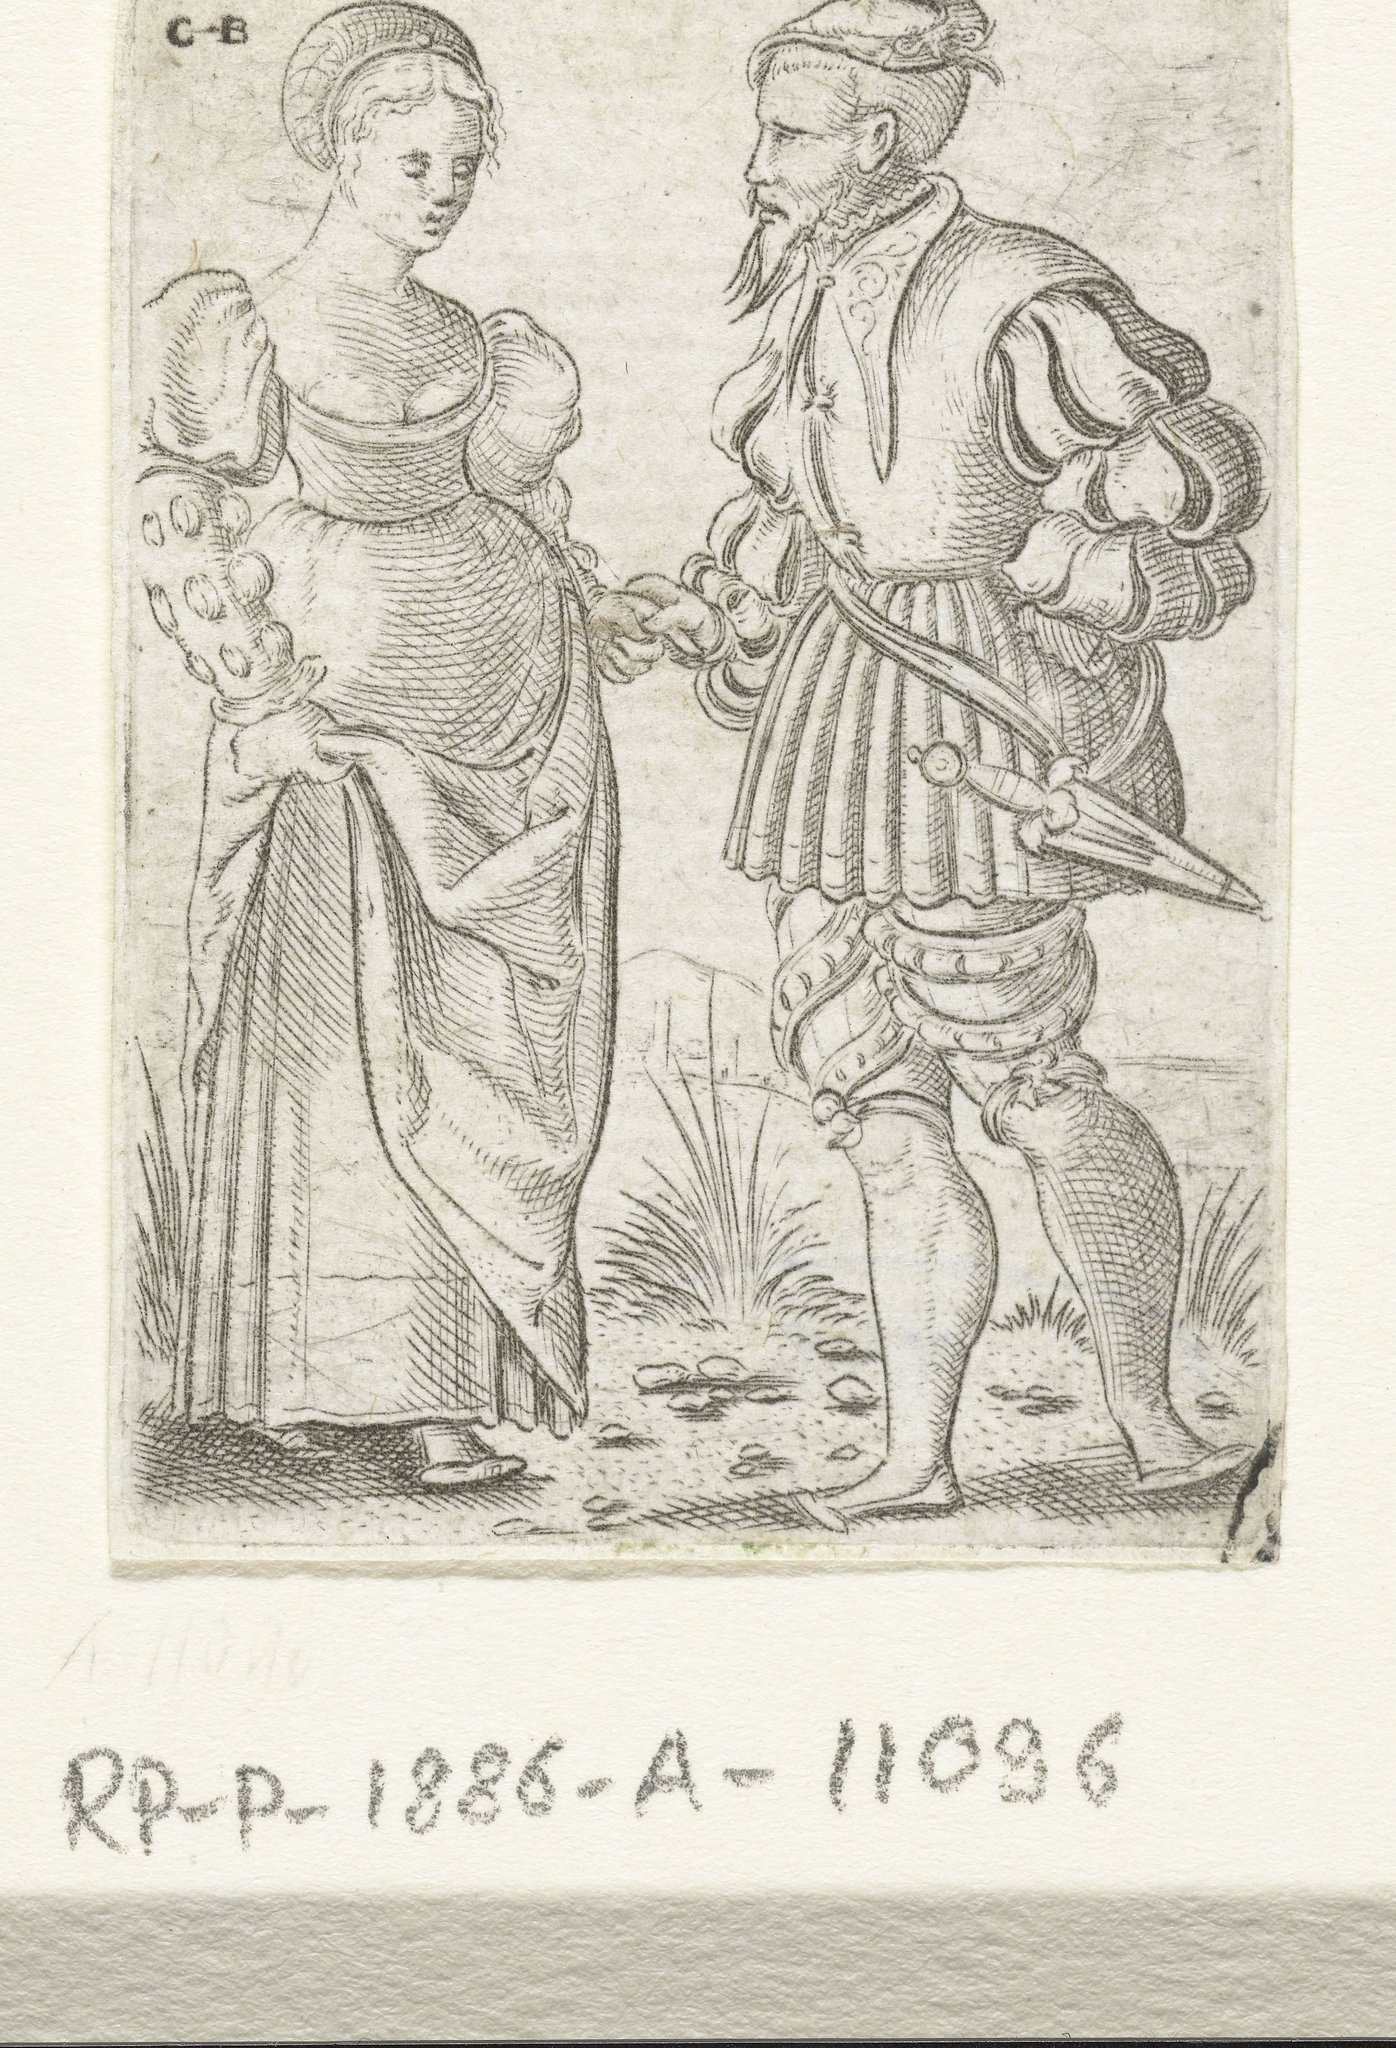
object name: print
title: Dansende stellen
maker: cornelis bos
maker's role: print maker, printer, publisher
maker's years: 1510-1566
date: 1546-1548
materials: paper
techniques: engraving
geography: nuremberg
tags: dancing at wedding feast - dd - out of doors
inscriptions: collector's mark: Lugt 2228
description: Prent uit een serie van 12 prenten met dansende stellen in de buitenlucht.